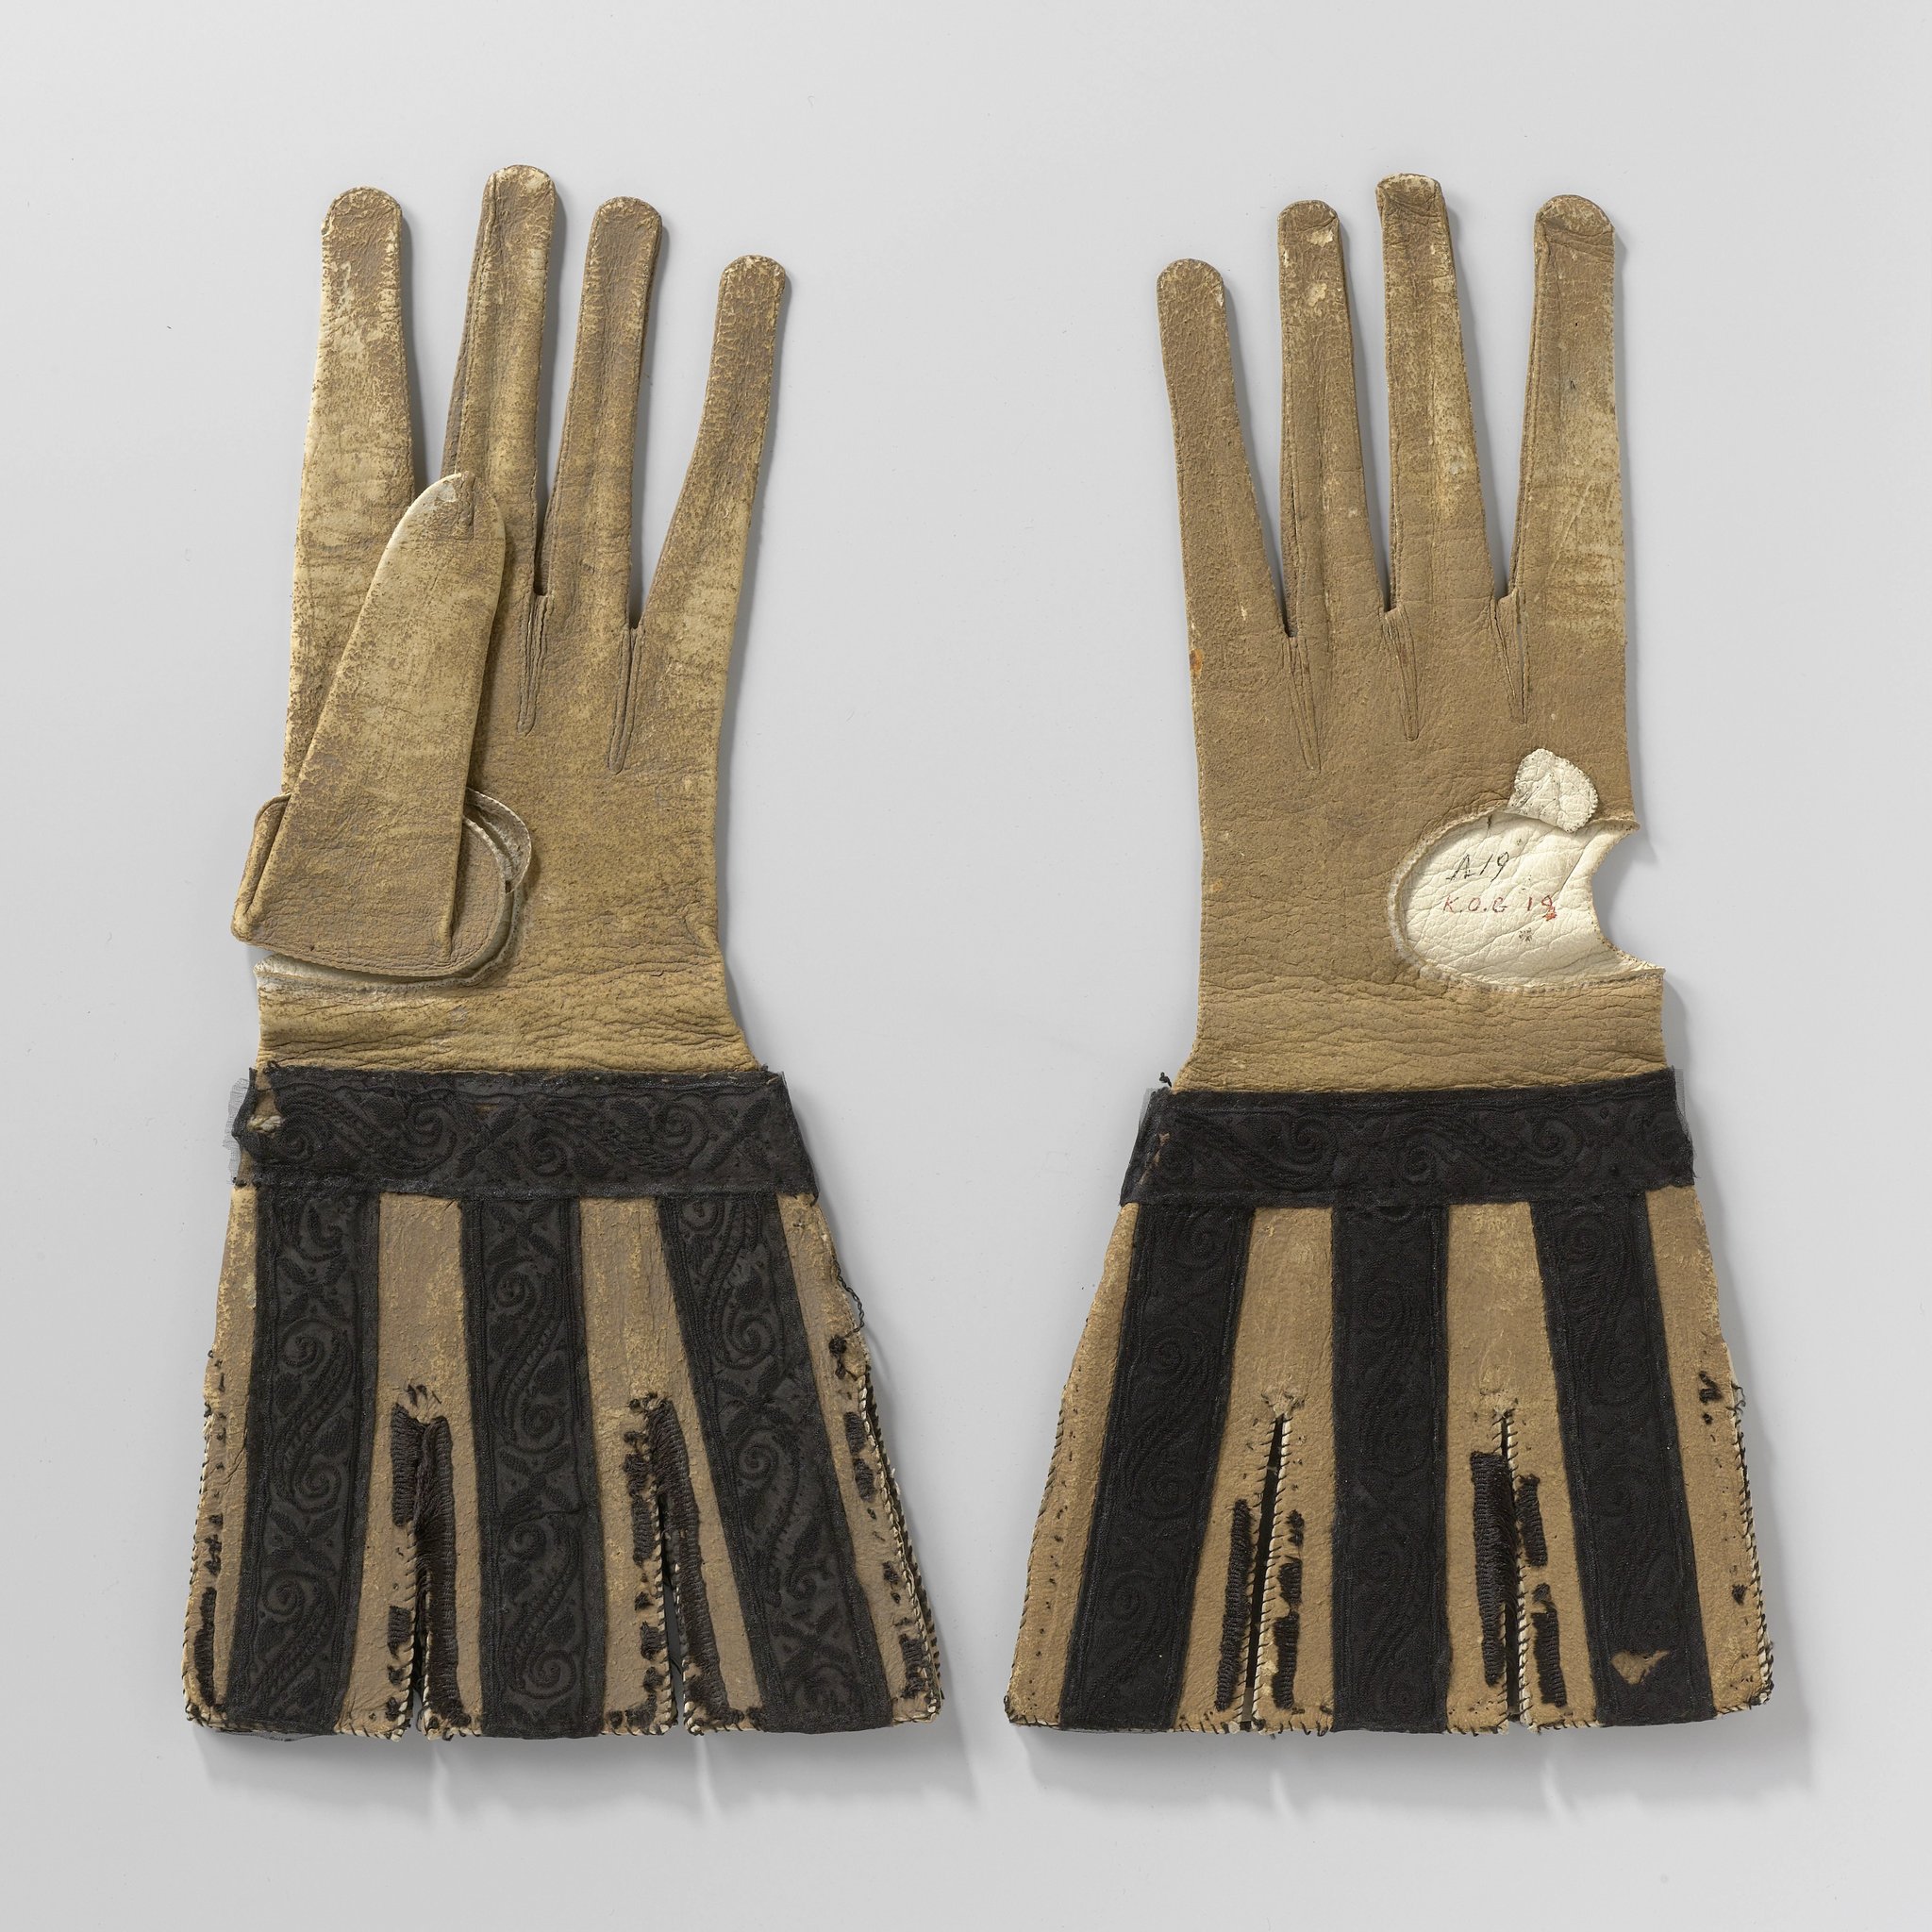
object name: glove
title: Handschoen van geiten(?)leer, okerkleurig geverfd met ingesneden, losse kappen versierd met zwart satijnband geborduurd met een floraal patroon in zwarte zijde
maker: Anonymous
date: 1600-1625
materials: dye, leather, paper, silk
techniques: treatment, embroidered, sewing, tanning, weave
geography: low countries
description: Linkerhandschoen van geiten(?)leer, okerkleurig geverfd met ingesneden, losse kappen versierd met zwart satijnband geborduurd met een floraal patroon in zwarte zijde. Model: lange smalle vingers waarvan het stiksel doorloopt boven op de hand om de illusie van nog langere vingers te wekken. De duim is gedeeltelijk los. Genaaid met groene zijde. De losse kappen zijn met grove steken van gele zijde aan de handschoen gezet. Deze kappen zijn verstevigd met drie lagen grijs papier en oorspronkelijk gevoerd met zwart satijn dat grotendeels is vergaan. Langs de insnijdingen zijn de kappen afgezet met langharig zwart zijden passement (grotendeels vergaan), dat vrij grove steken van zwarte zijde bedekt. De hand is ongevoerd. Versiering: de buitenkant van de handschoen lijkt met een pasta-achtige verf okergeel te zijn gekleurd. De kappen zijn versierd met zwart satijnband, dat geborduurd met zwarte zijde waarbij de steken door het leer én het papier zijn gestoken. Het blad- en bloemmotief is opgebouwd uit voluten in koordsteek over een opgelegde draad van zwarte zijde, 'klimop'bladeren in platsteek en bolletjes in de knoopjessteek.